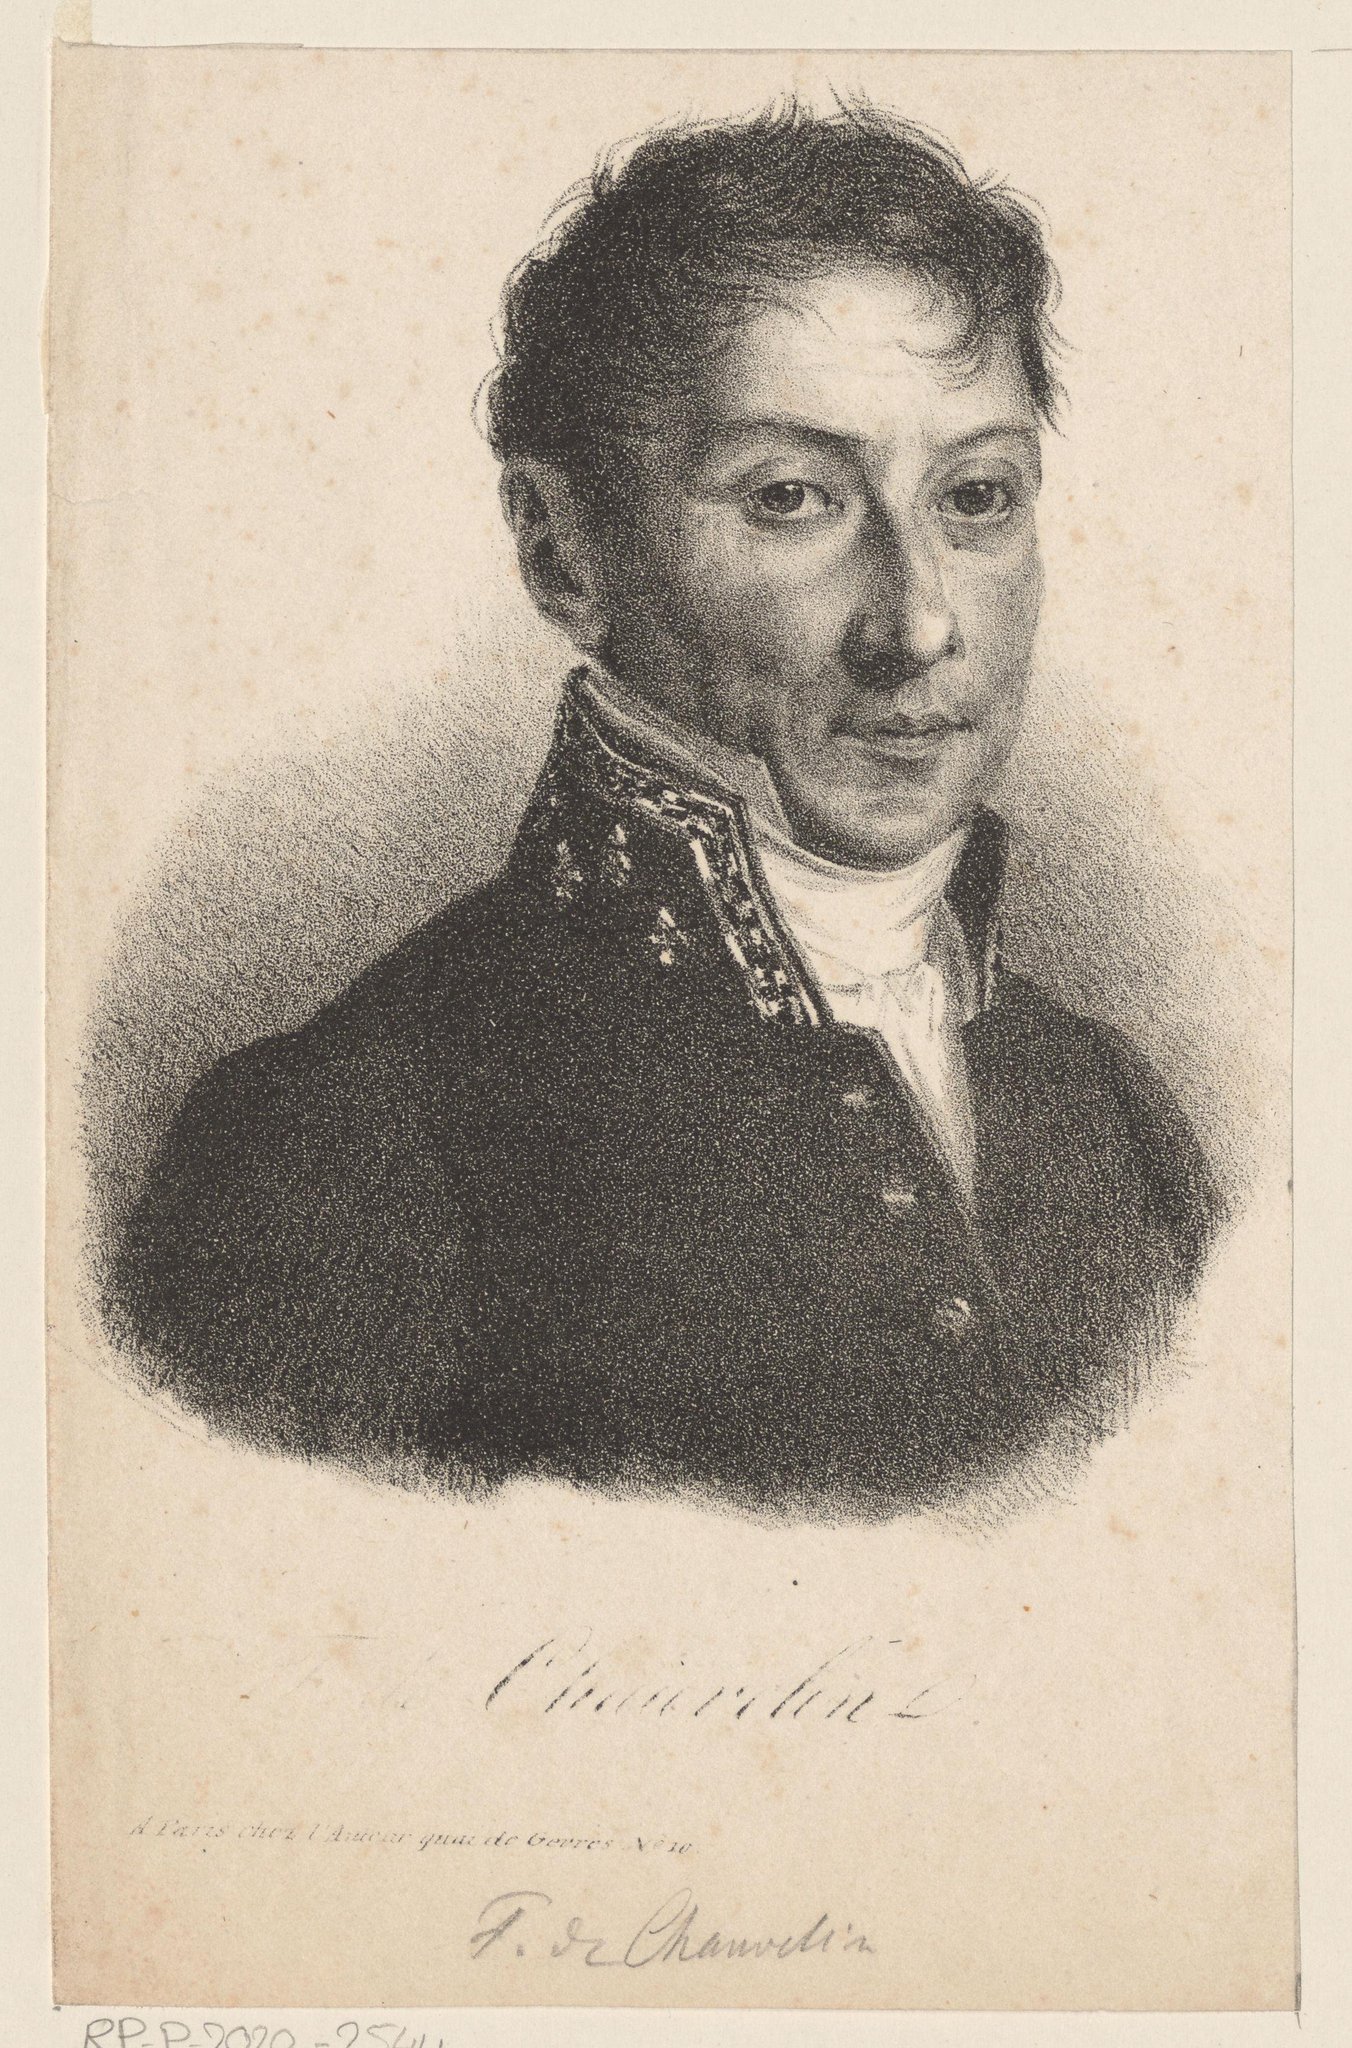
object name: print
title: Portret van François Bernard de Chauvelin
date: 1786-1832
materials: paper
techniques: lithograph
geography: paris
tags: paris, politician, historical persons